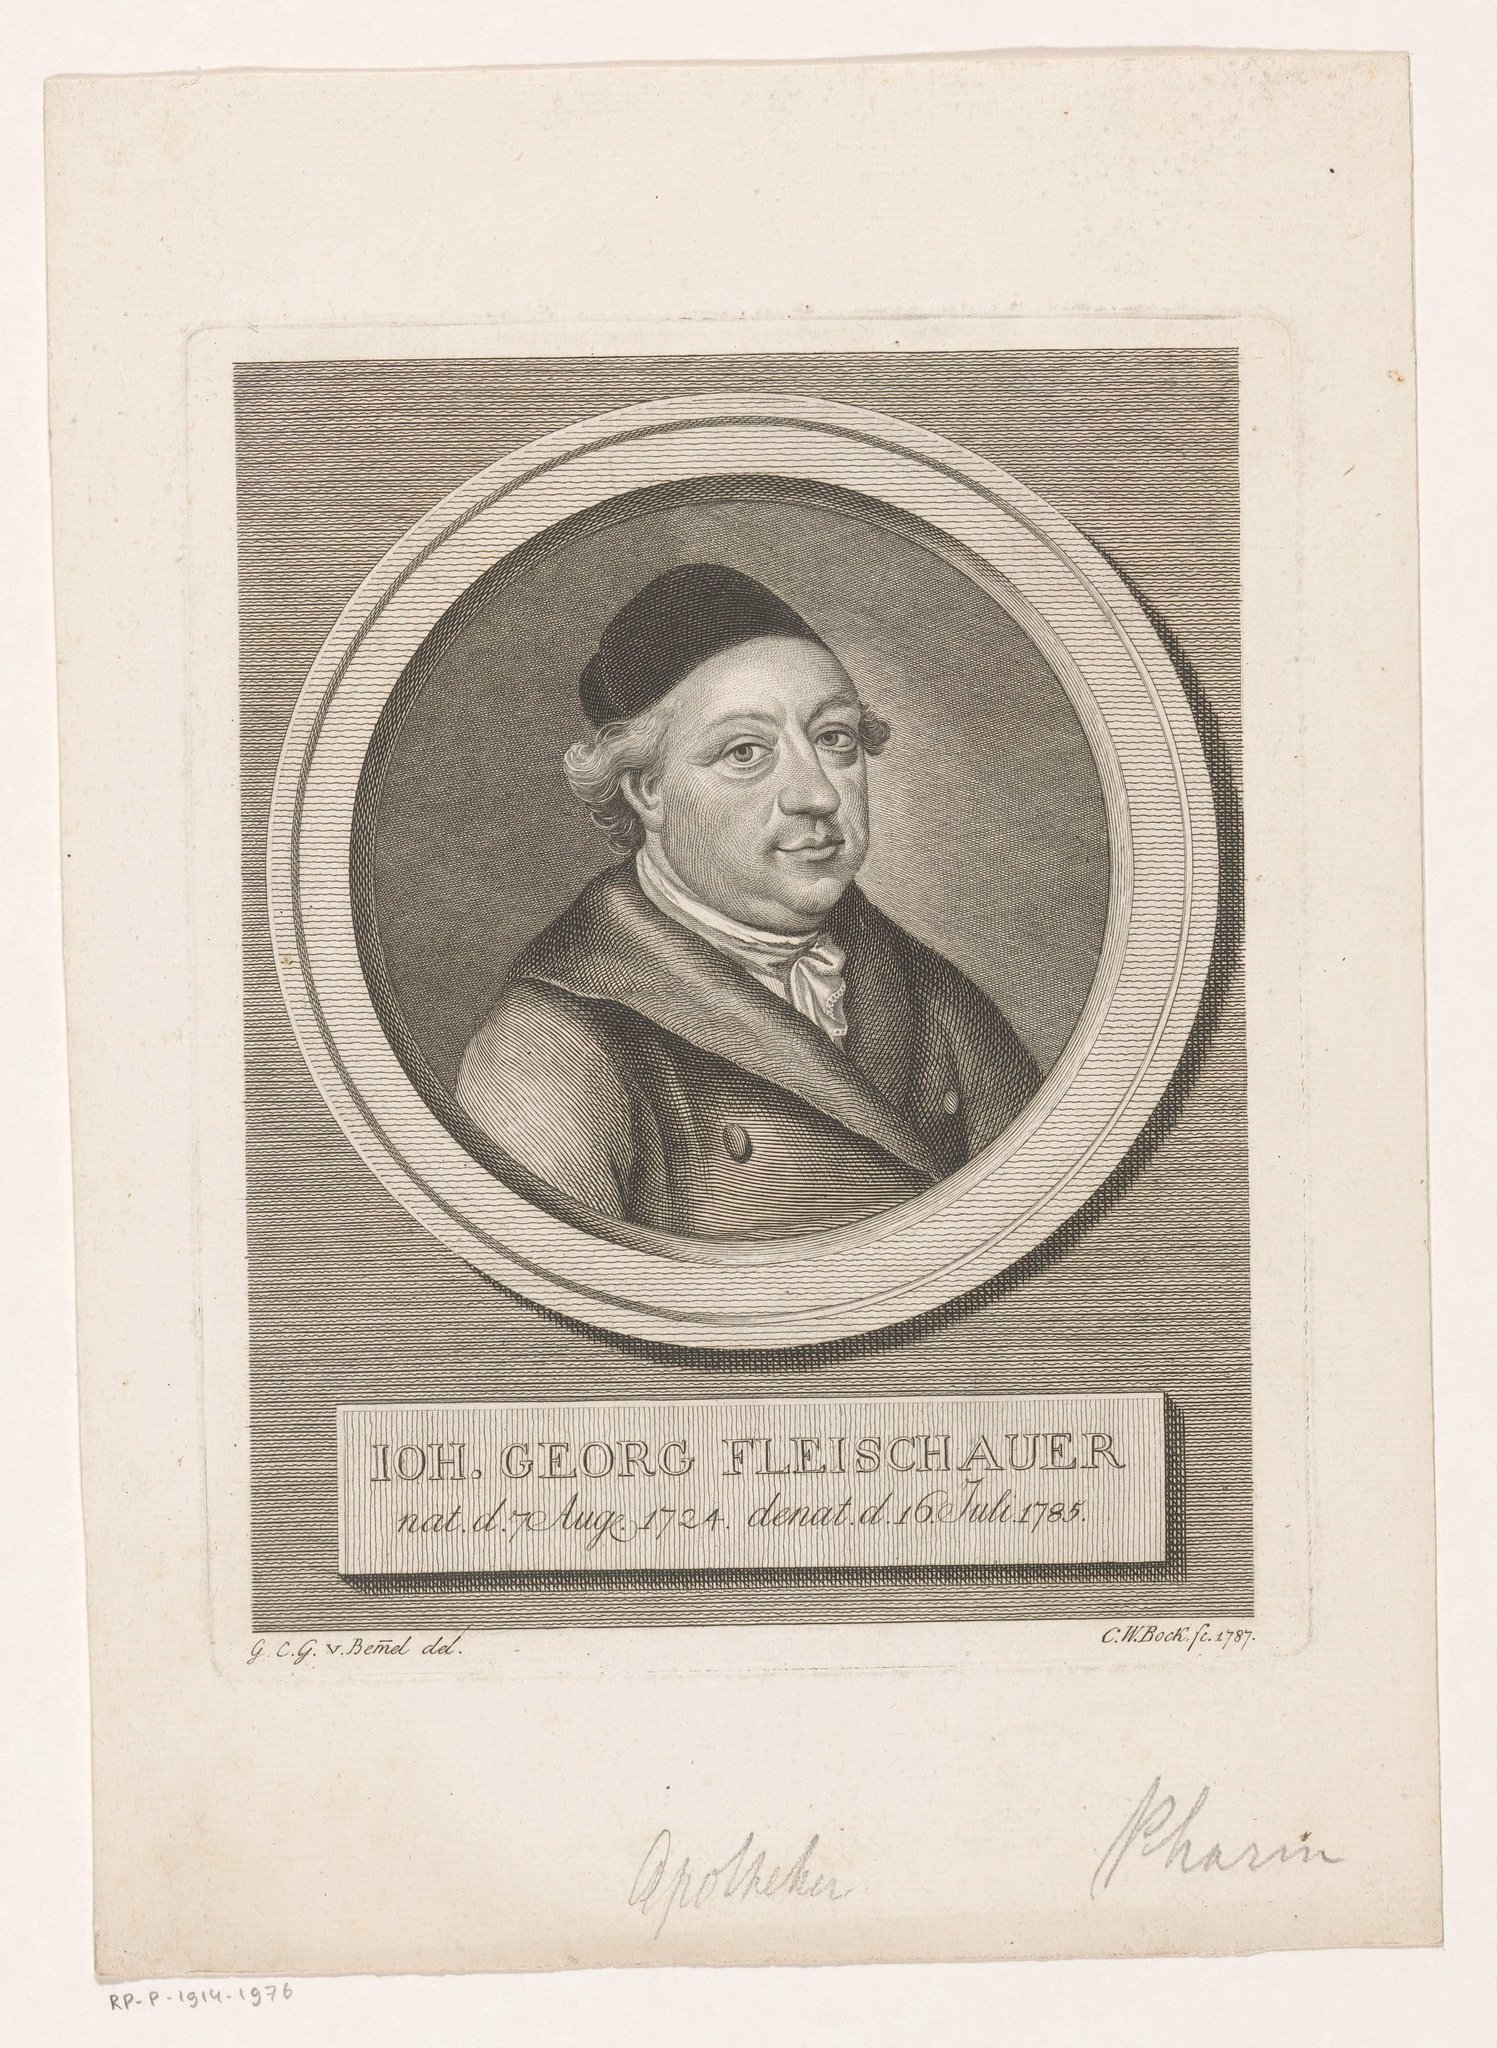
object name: print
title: Portret van Johann Georg Fleischauer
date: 1787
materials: paper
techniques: engraving, etching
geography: nuremberg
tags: historical persons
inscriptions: collector's mark: Lugt 2228